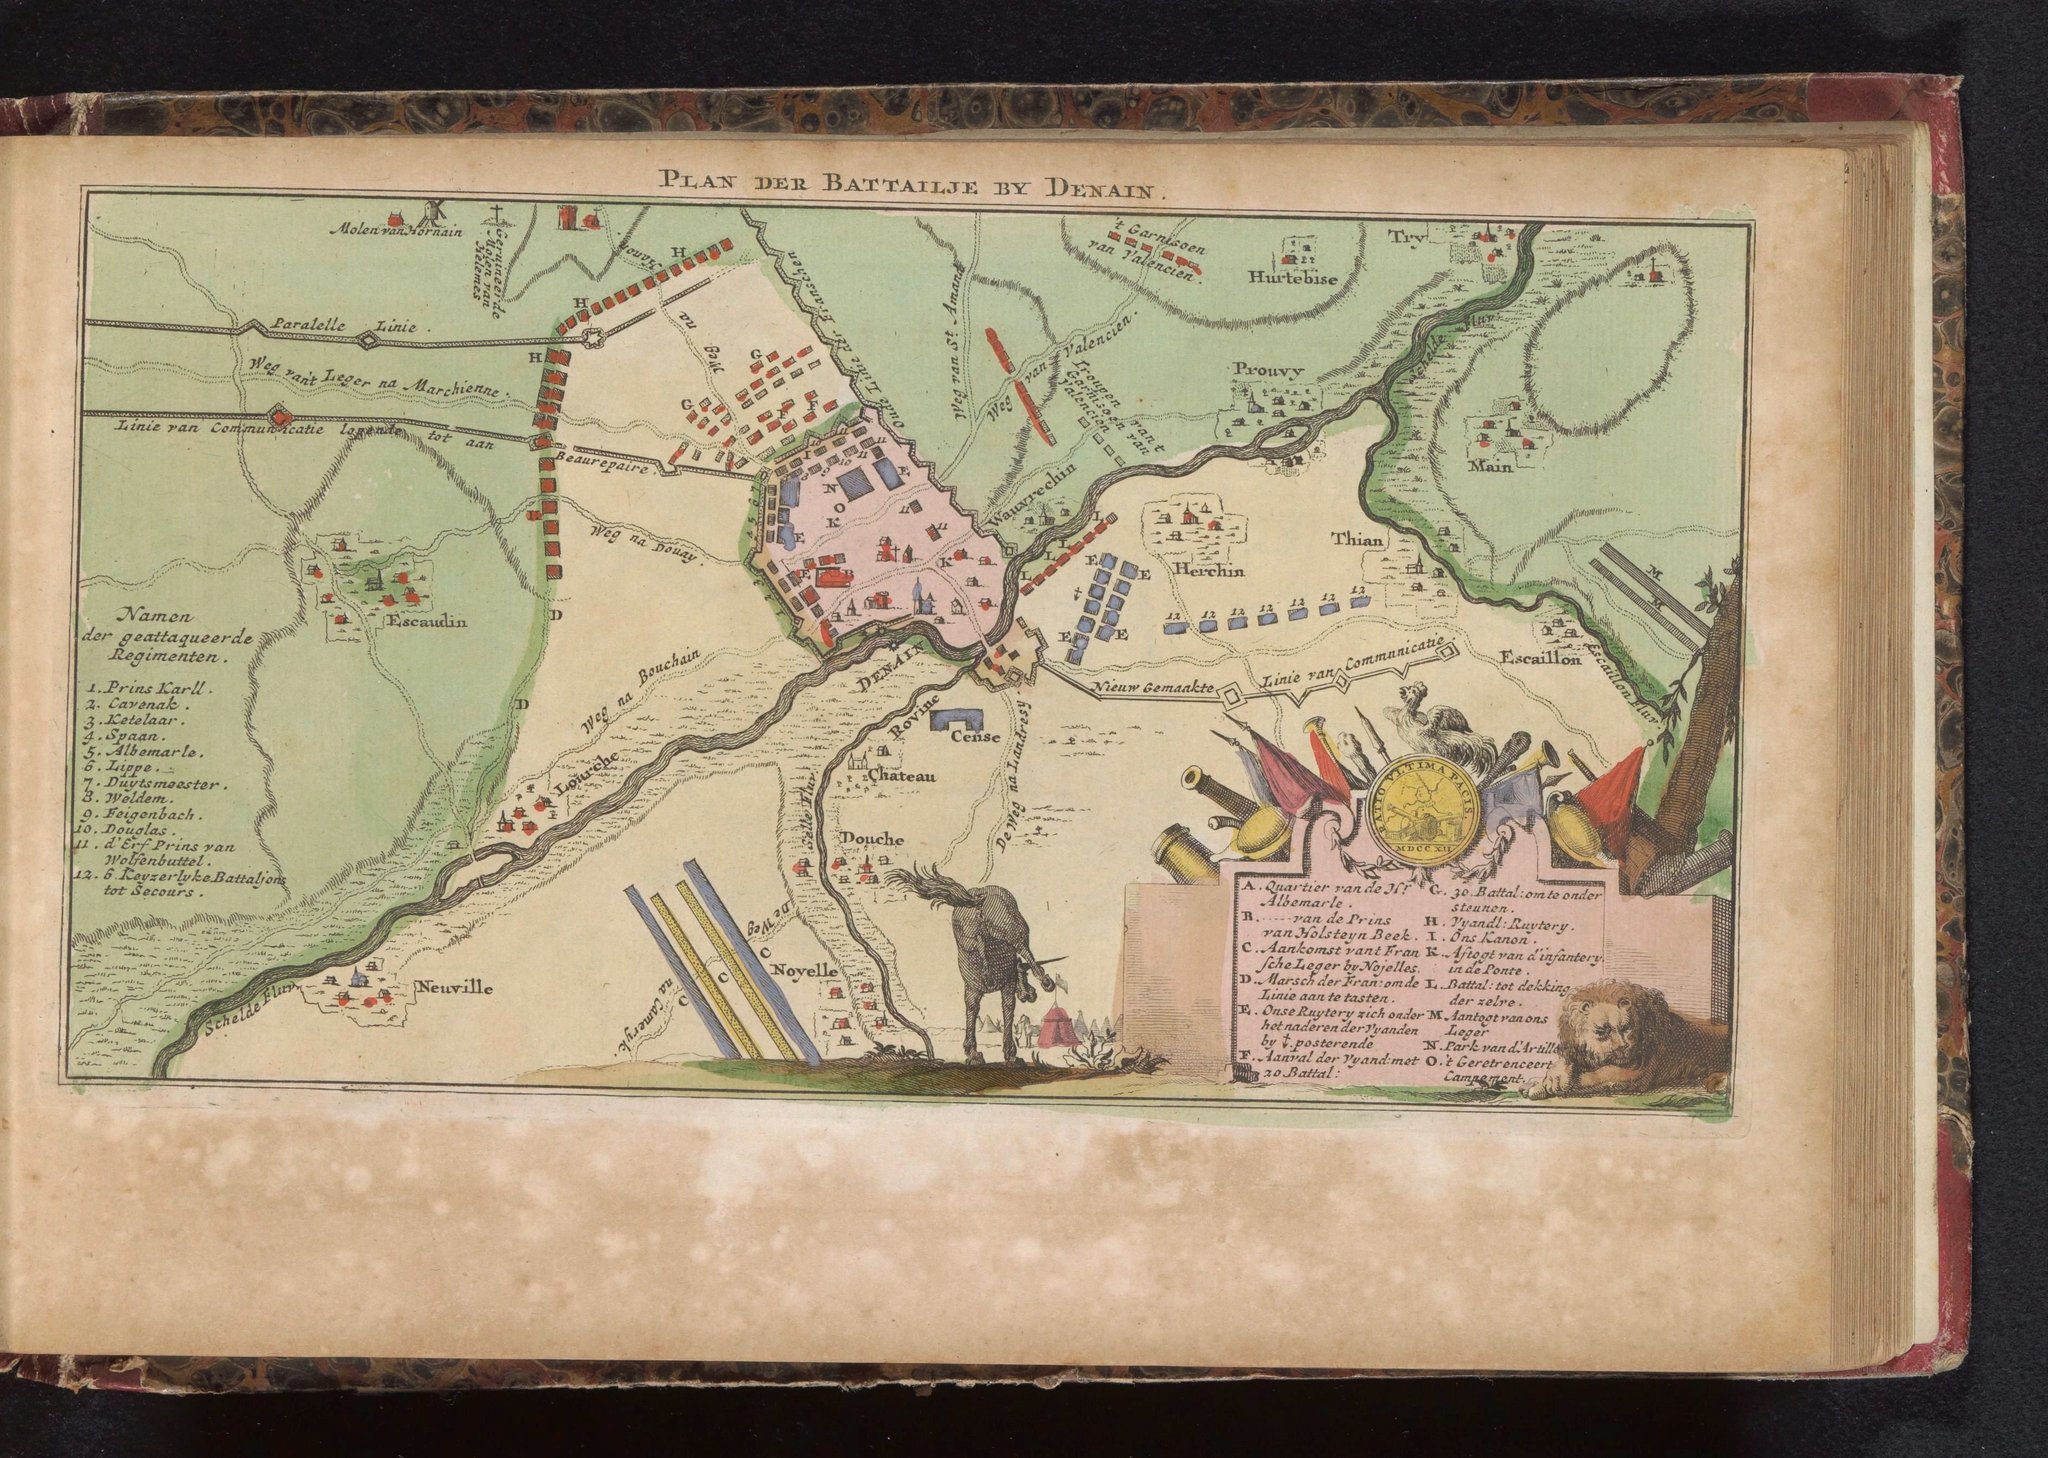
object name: print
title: Plan der Battailje by Denain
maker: Anonymous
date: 1735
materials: paper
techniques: engraving, etching, hand coloring, lacquer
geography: northern netherlands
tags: maps of separate countries or regions, battle (+ land forces)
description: Kaart met de slagordes van de troepen bij de slag bij Denain op 24 juli 1712, een overwinning van de Fransen op de Geallieerden. Rechtsonder een kraaiende Franse haan bovenop de legenda, hierbij een liggende Nederlandse leeuw en een bokkende Engelse eenhoorn. Onderdeel van een atlas met 223 kaarten van landen en steden en oorlogstaferelen in Europa in de periode ca. 1690-1735.